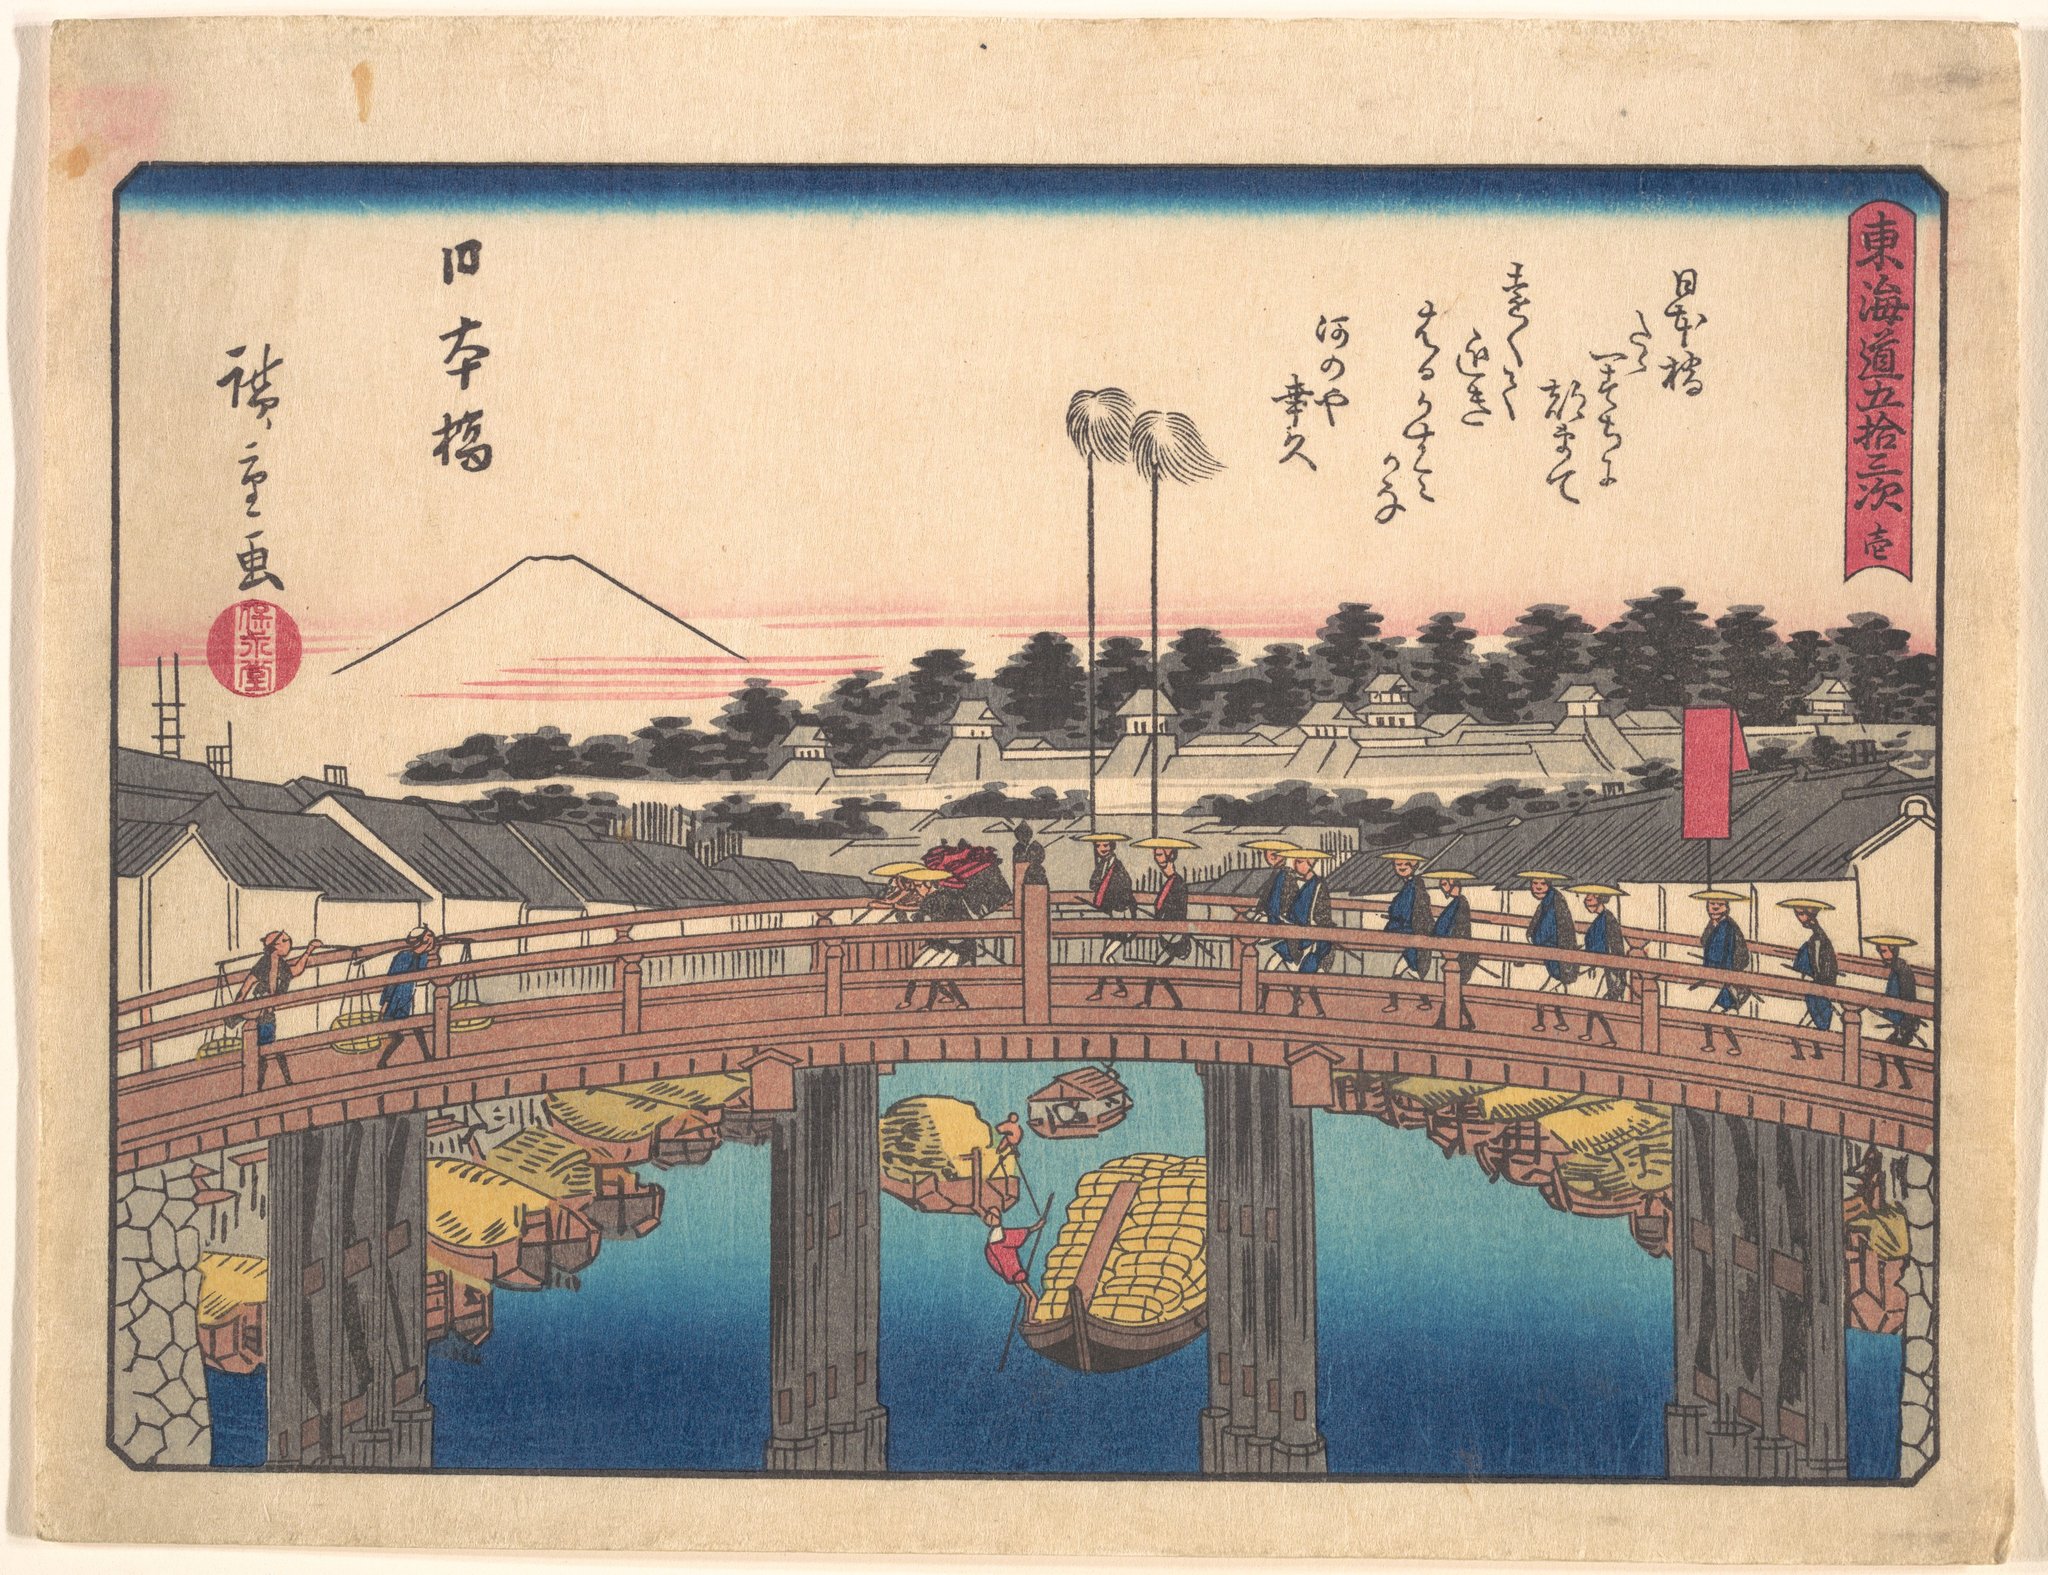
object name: print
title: 東海道五十三次 日本橋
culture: japanese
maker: utagawa hiroshige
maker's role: artist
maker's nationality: japanese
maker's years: 1797-1858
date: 1901-1933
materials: ink, paper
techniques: woodblock print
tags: human figures,houses,bridges,trees,boats